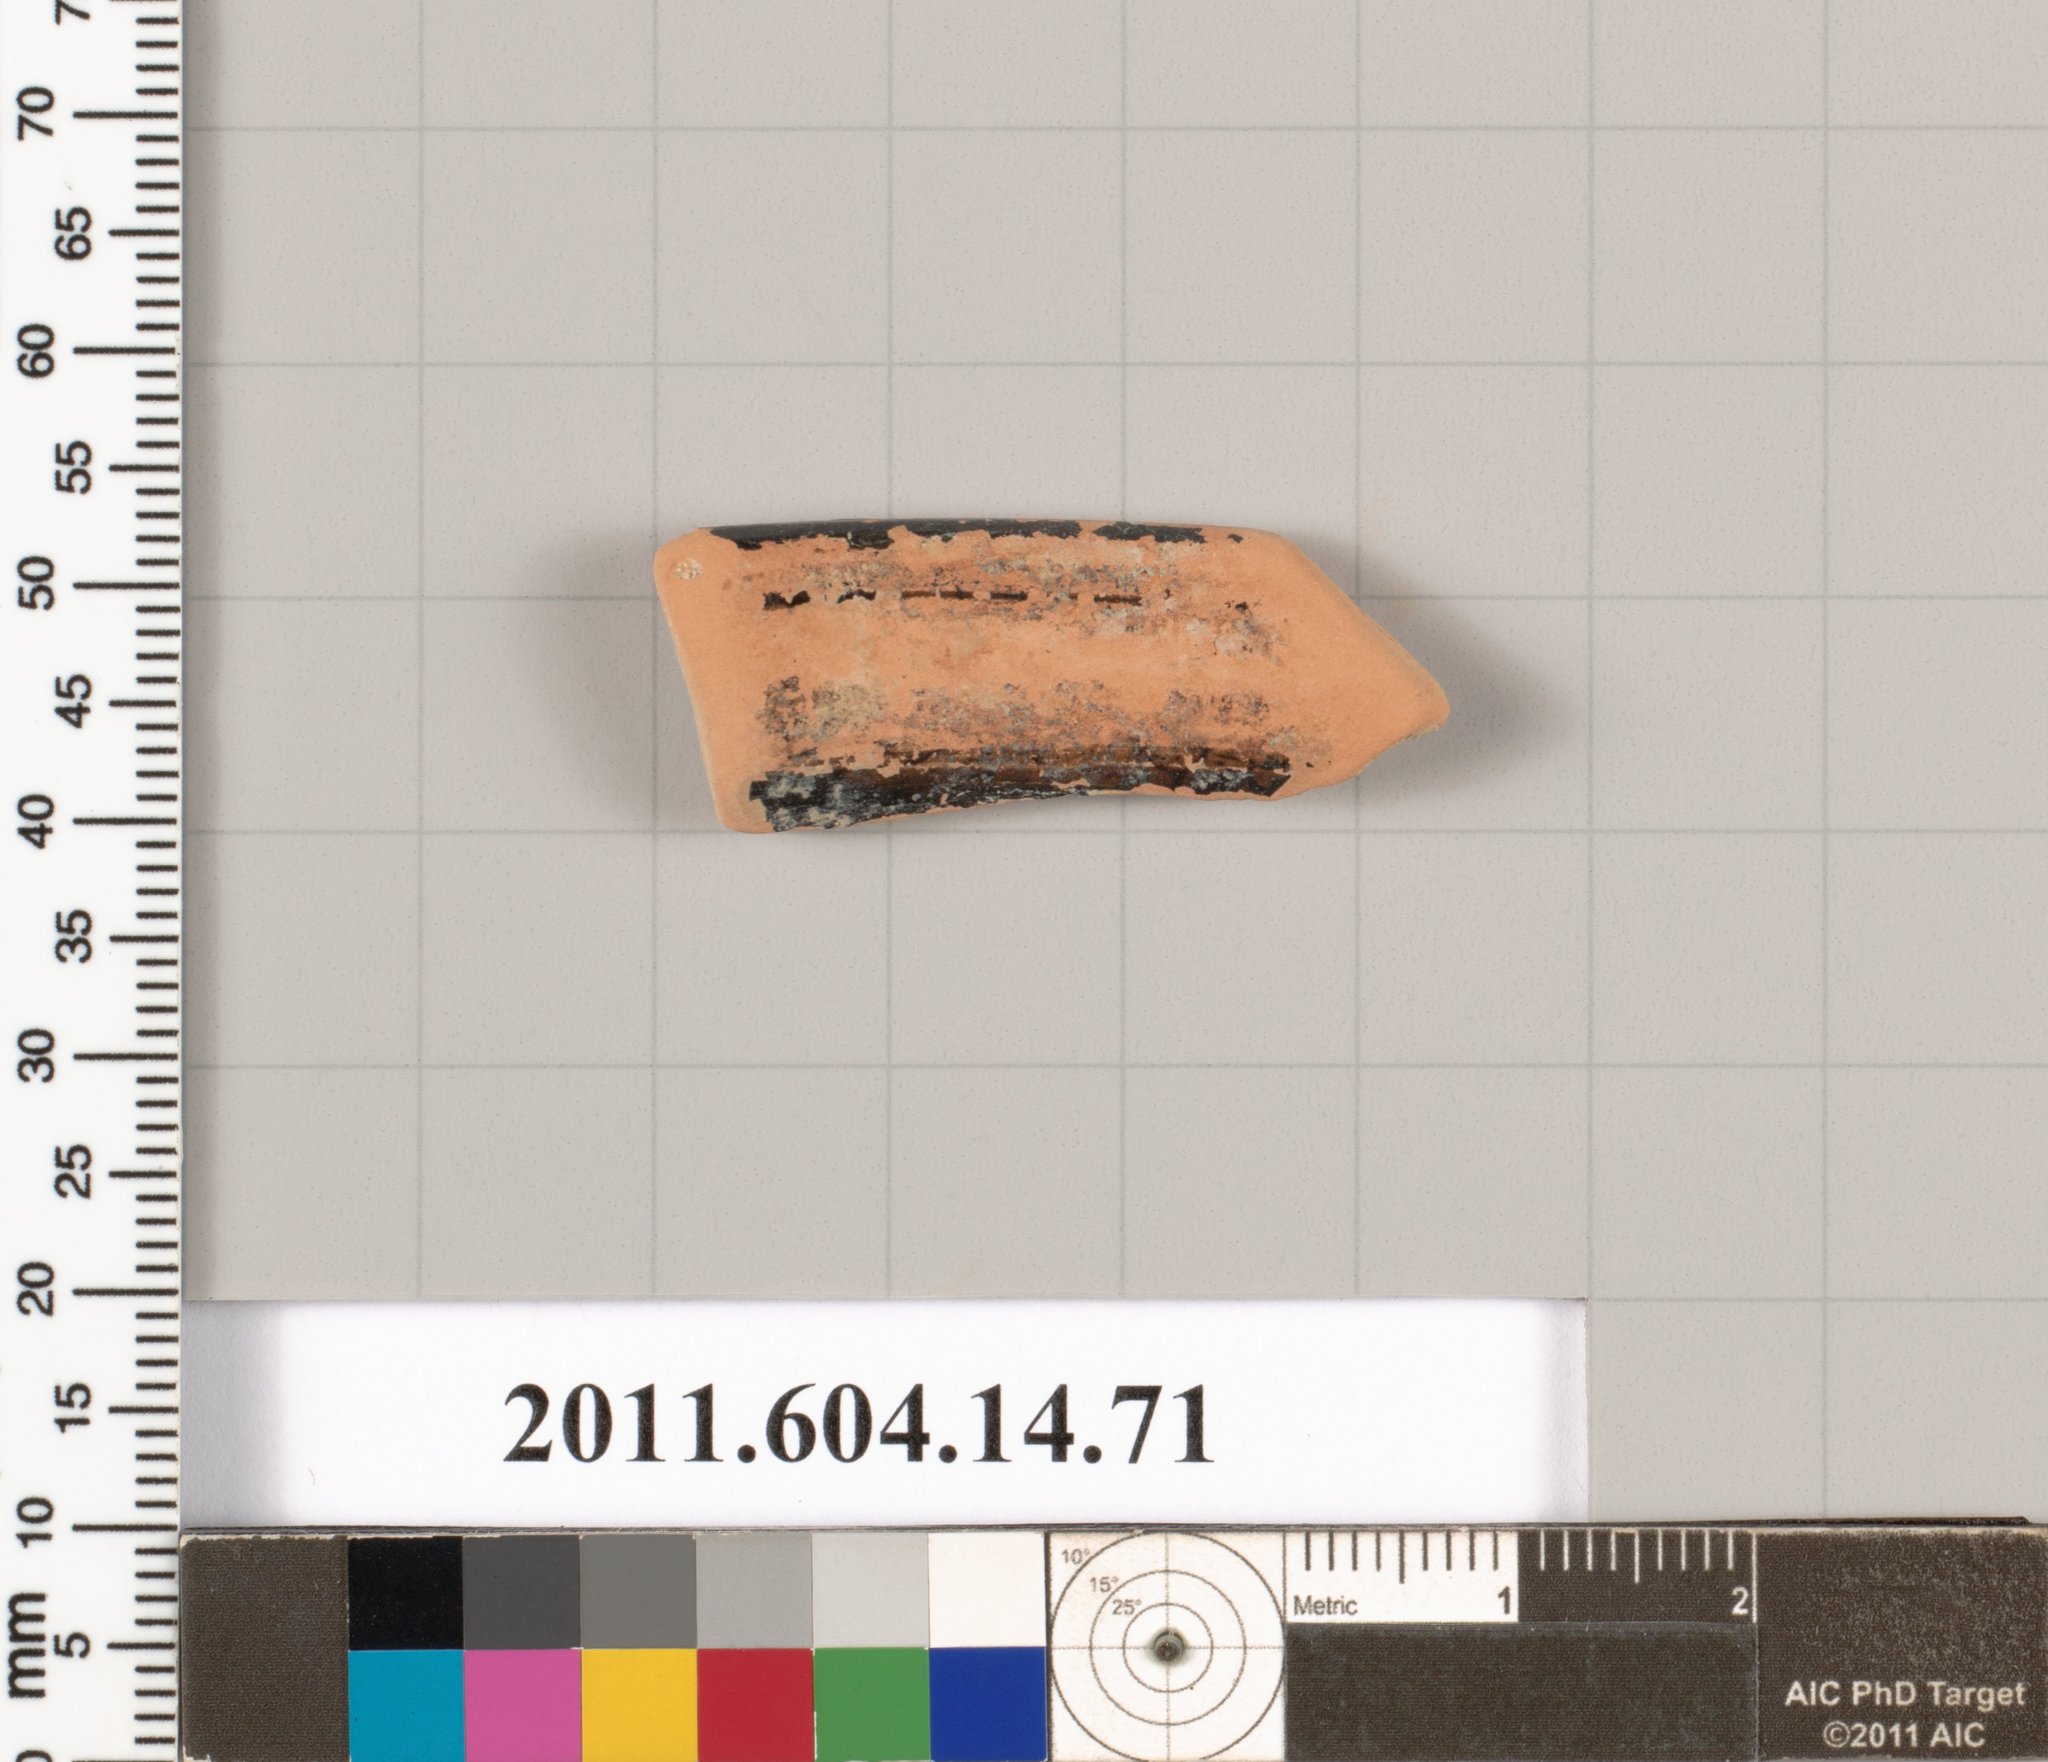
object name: kylix fragment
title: Terracotta rim fragment of a kylix (drinking cup)?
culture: unknown fabric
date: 600-401 BCE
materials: terracotta